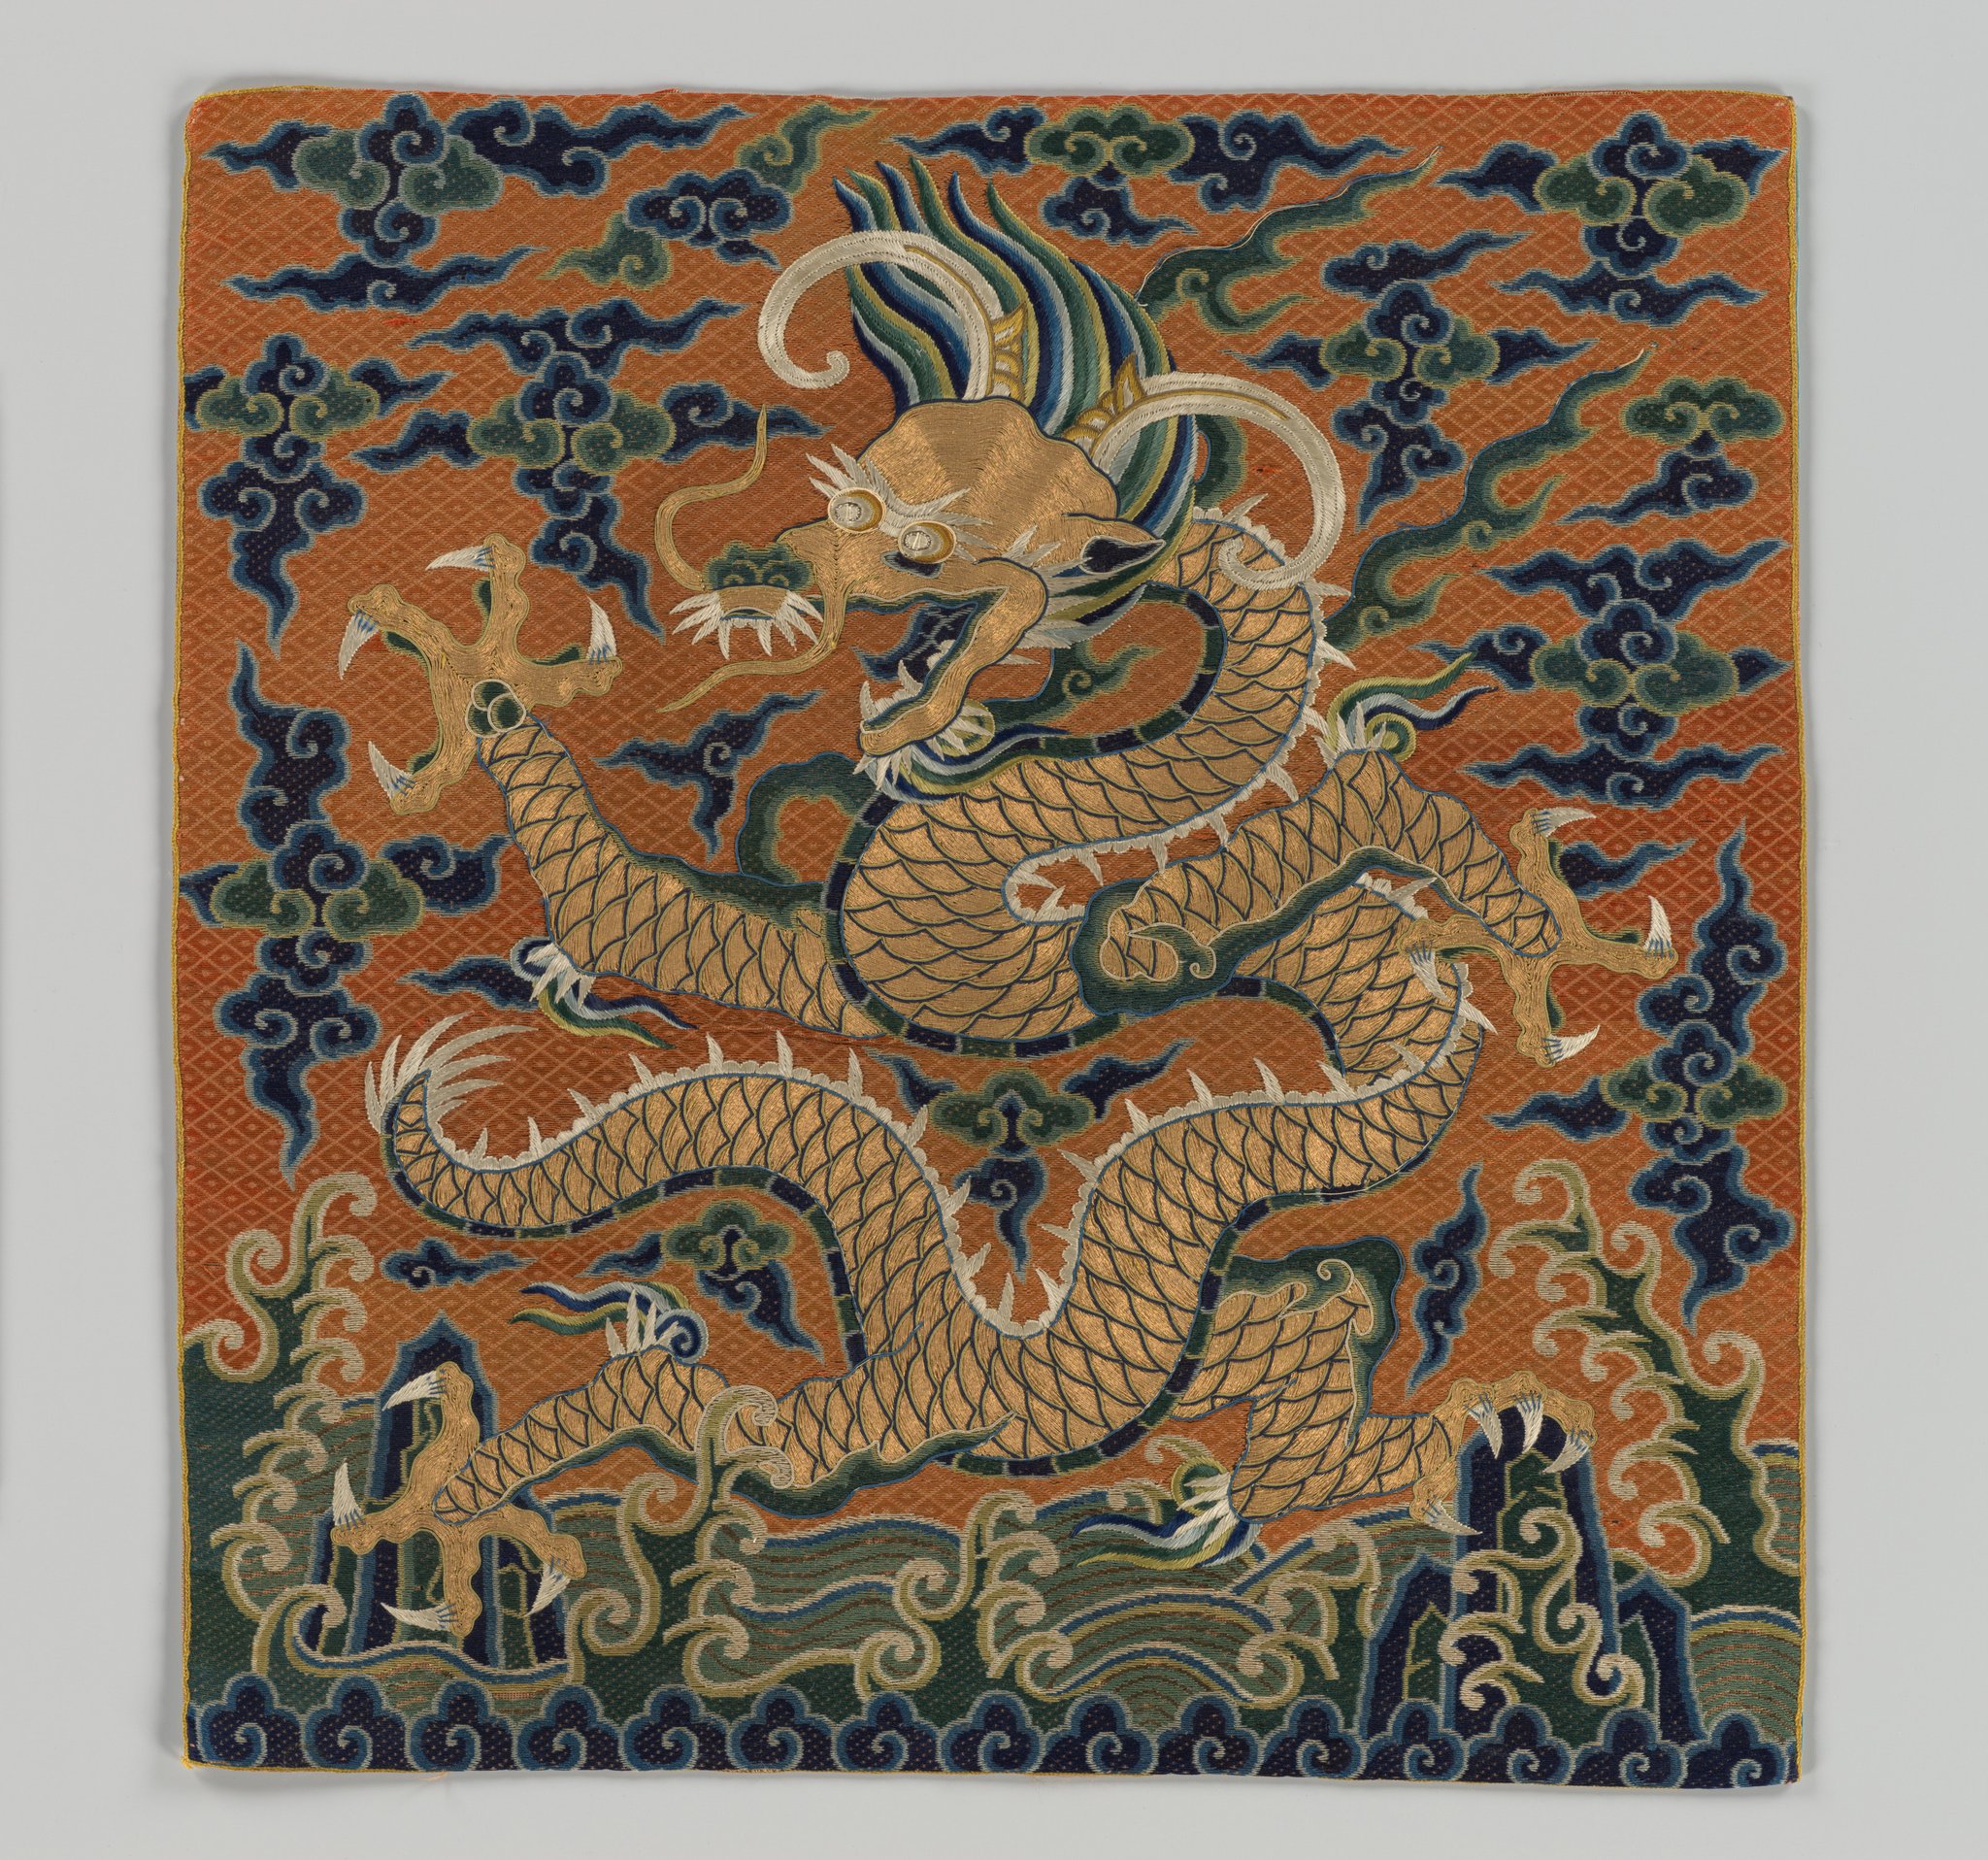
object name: rank badge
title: Rank badge with ox-horn dragon (douniu)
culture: chinese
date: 1567-1633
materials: textile, gold thread, silk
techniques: embroidery